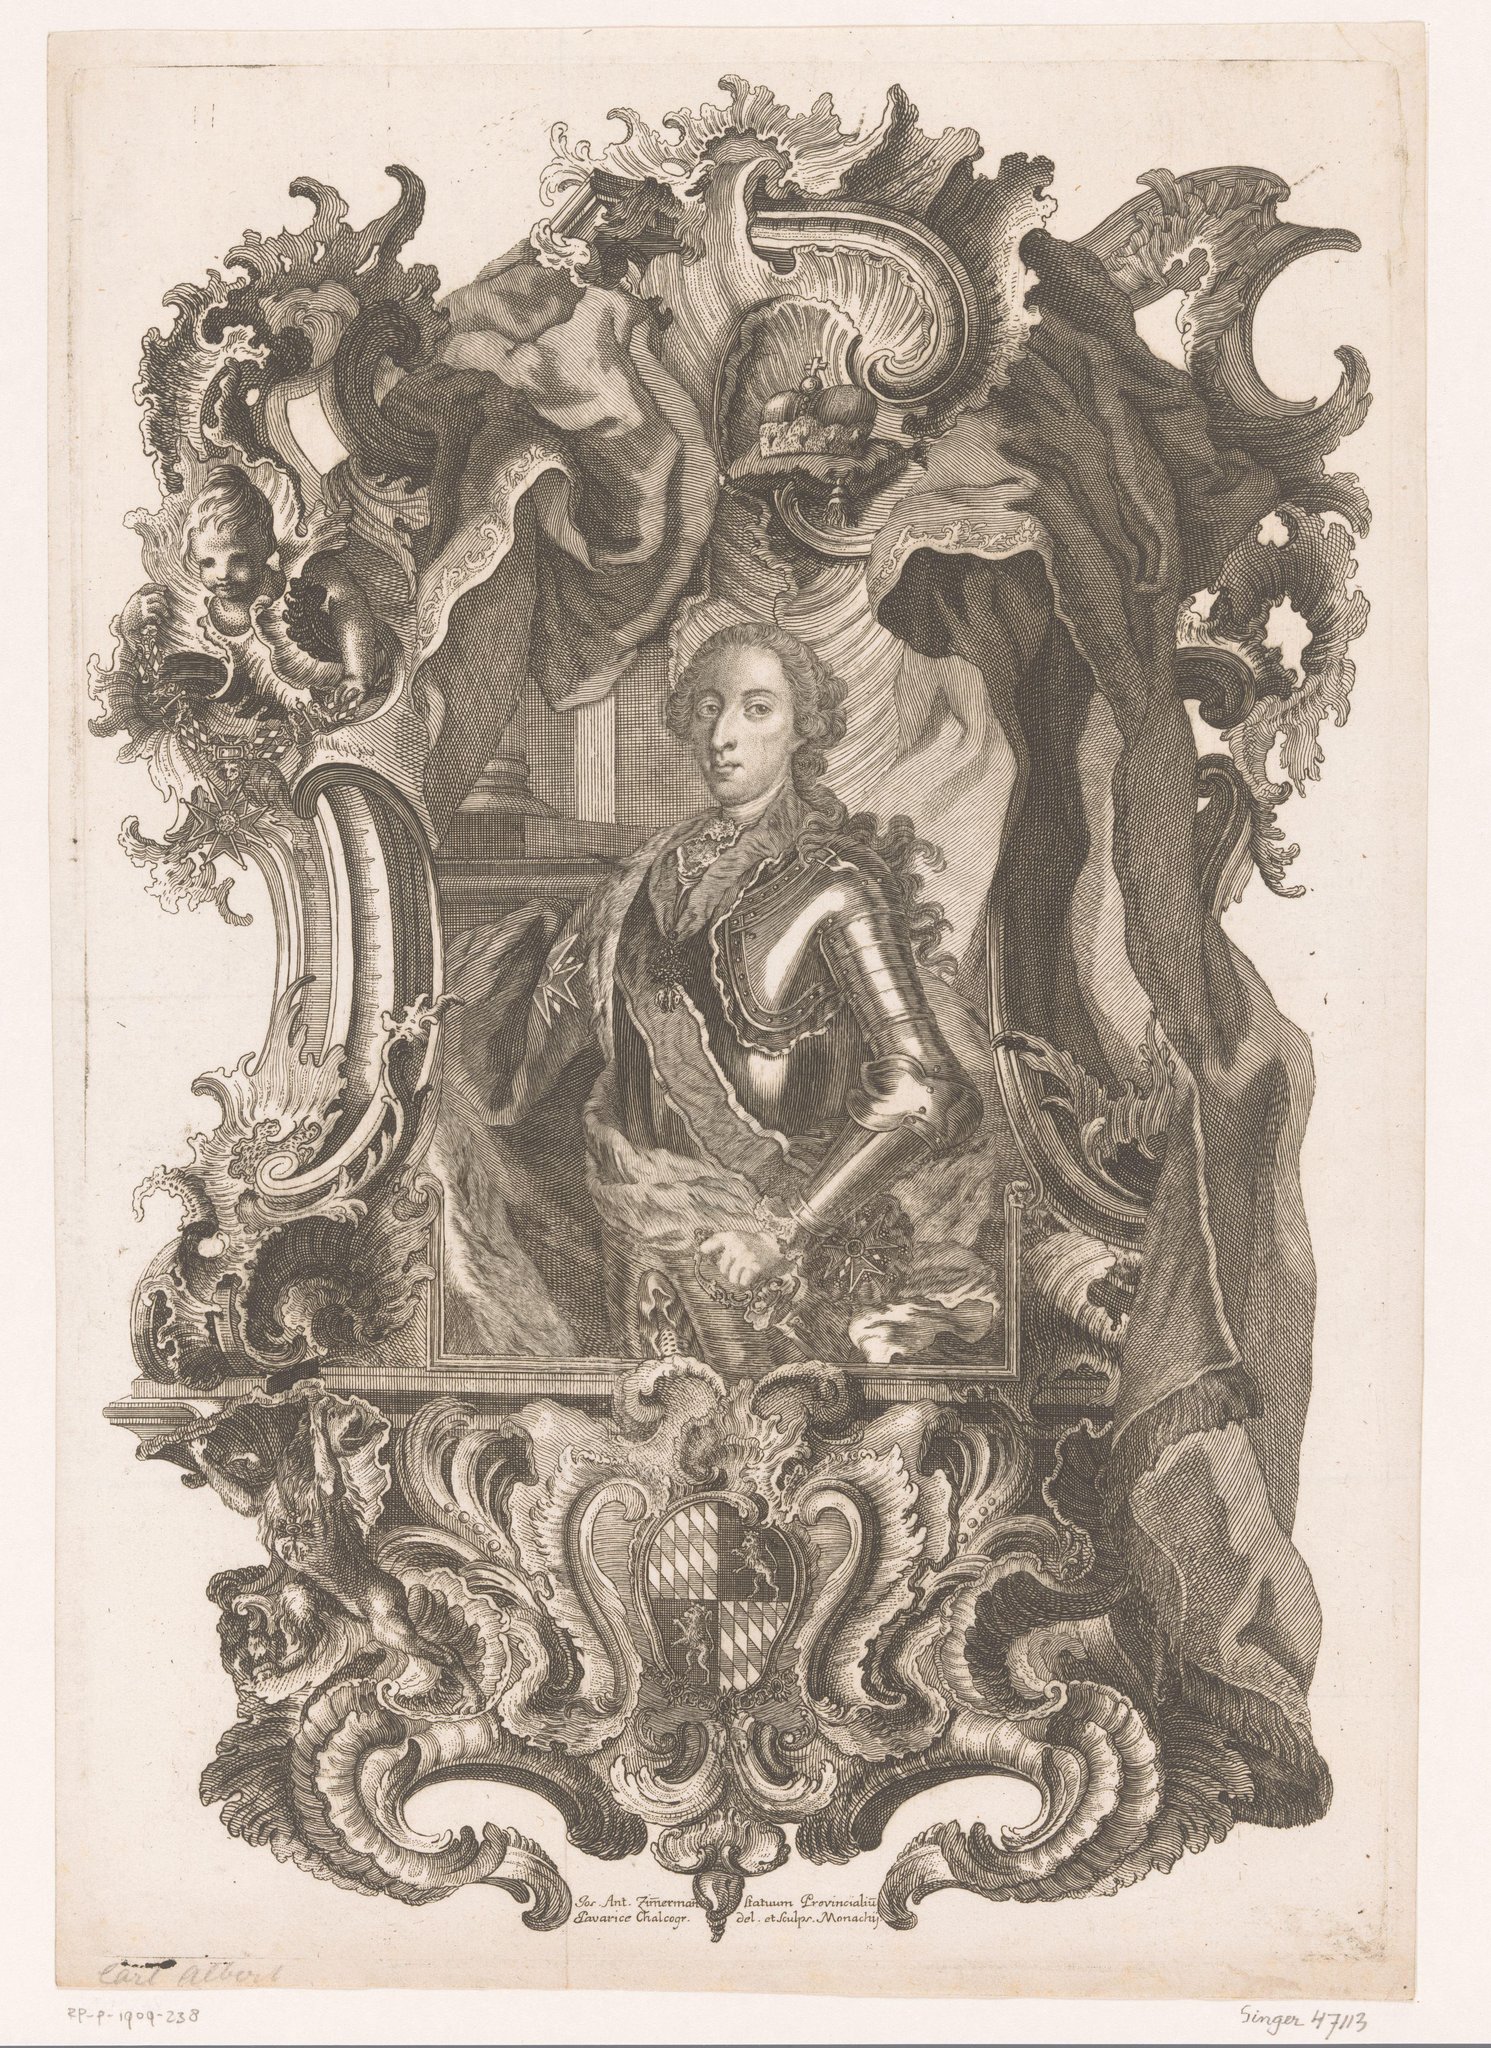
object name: print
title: Portret van Duits keizer Karel VII Albert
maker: joseph anton zimmermann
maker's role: draughtsman, print maker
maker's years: 1705-1797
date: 1725-1797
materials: paper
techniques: engraving, etching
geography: munich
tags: brussels, karel vii albrecht (duits keizer), historical persons, knighthood order of the golden fleece - insignia of a knighthood order, e.g.: badge, chain (with name of order)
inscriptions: collector's mark: Lugt 2228